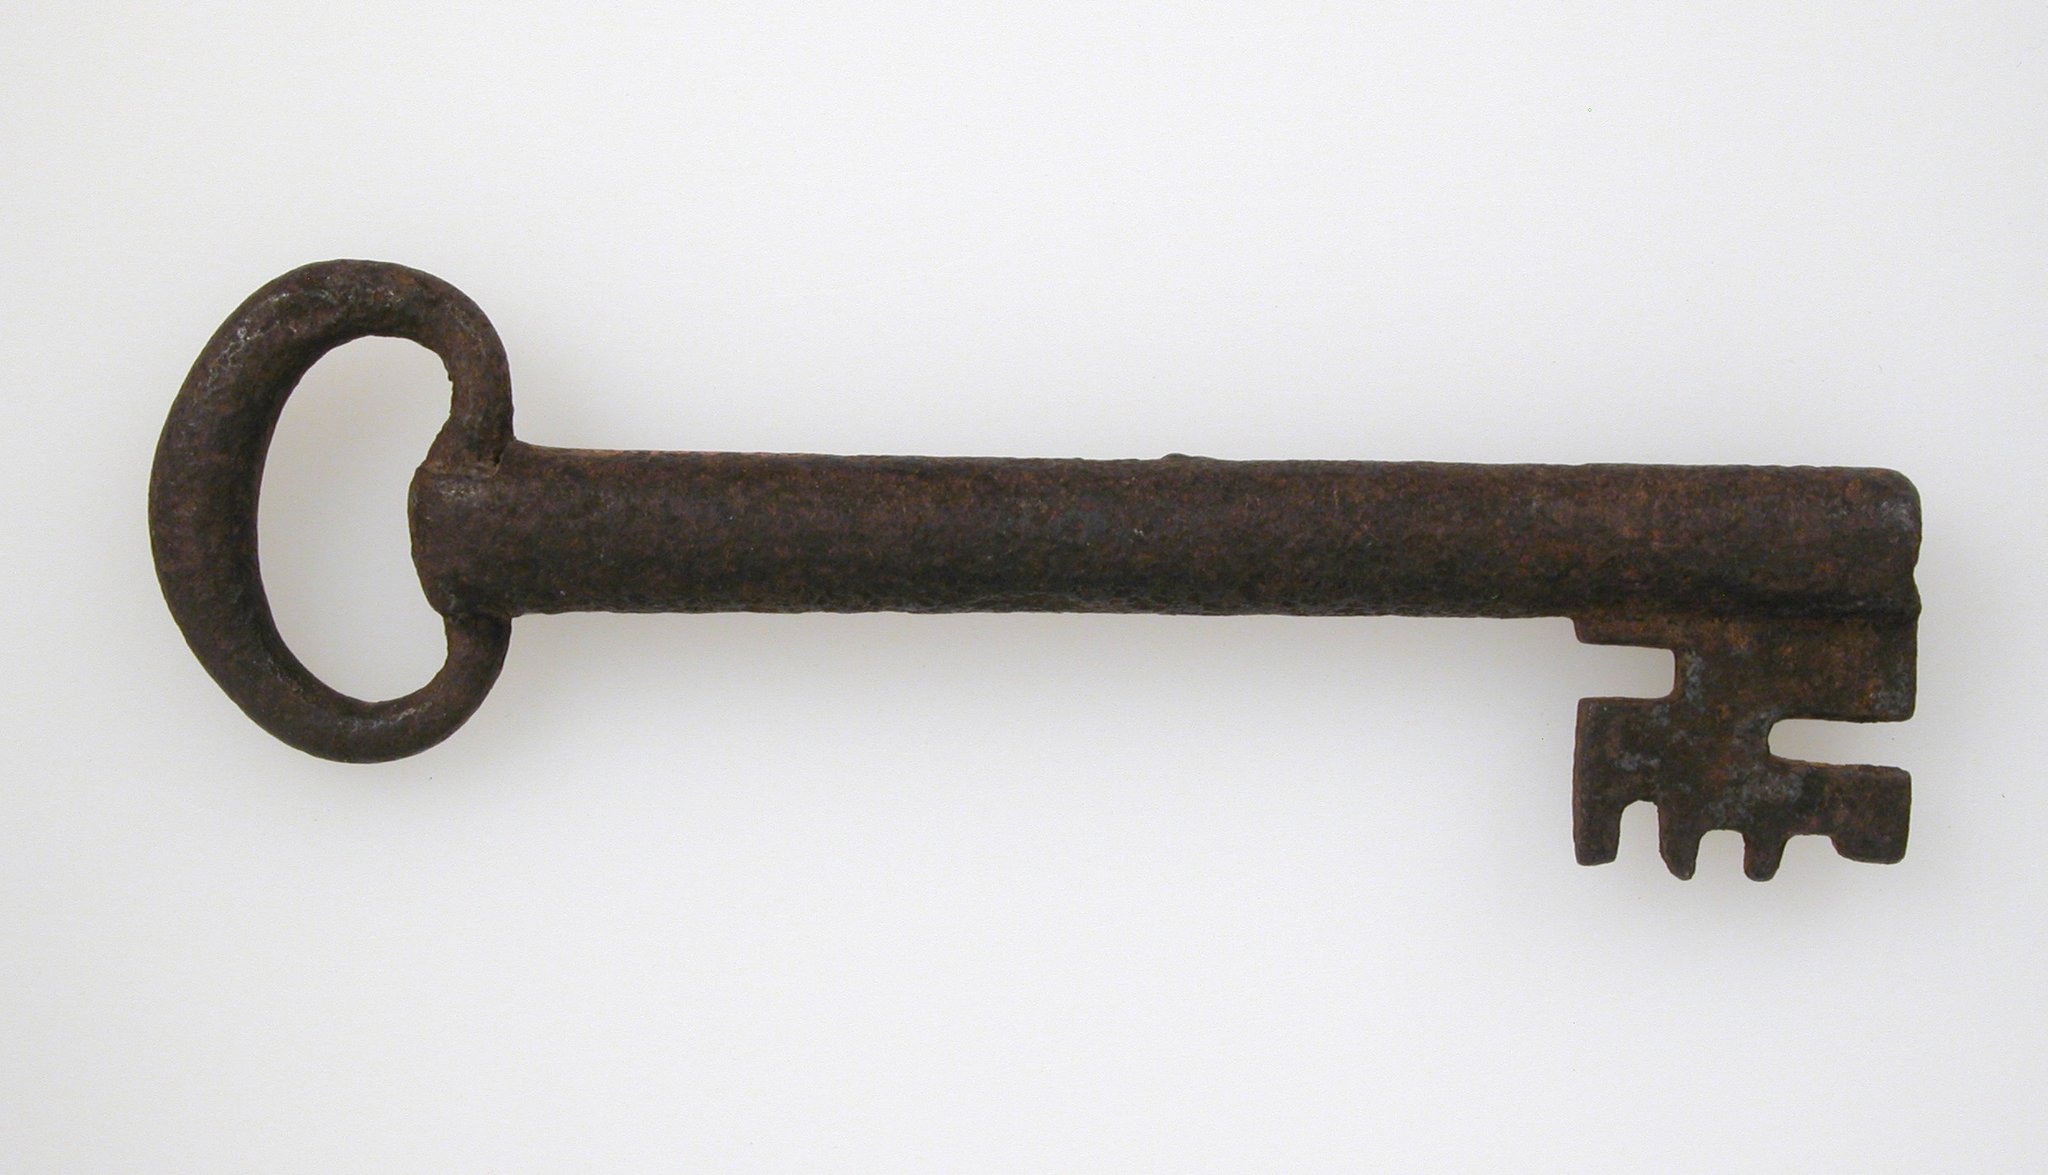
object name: key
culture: german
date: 1301-1400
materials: iron